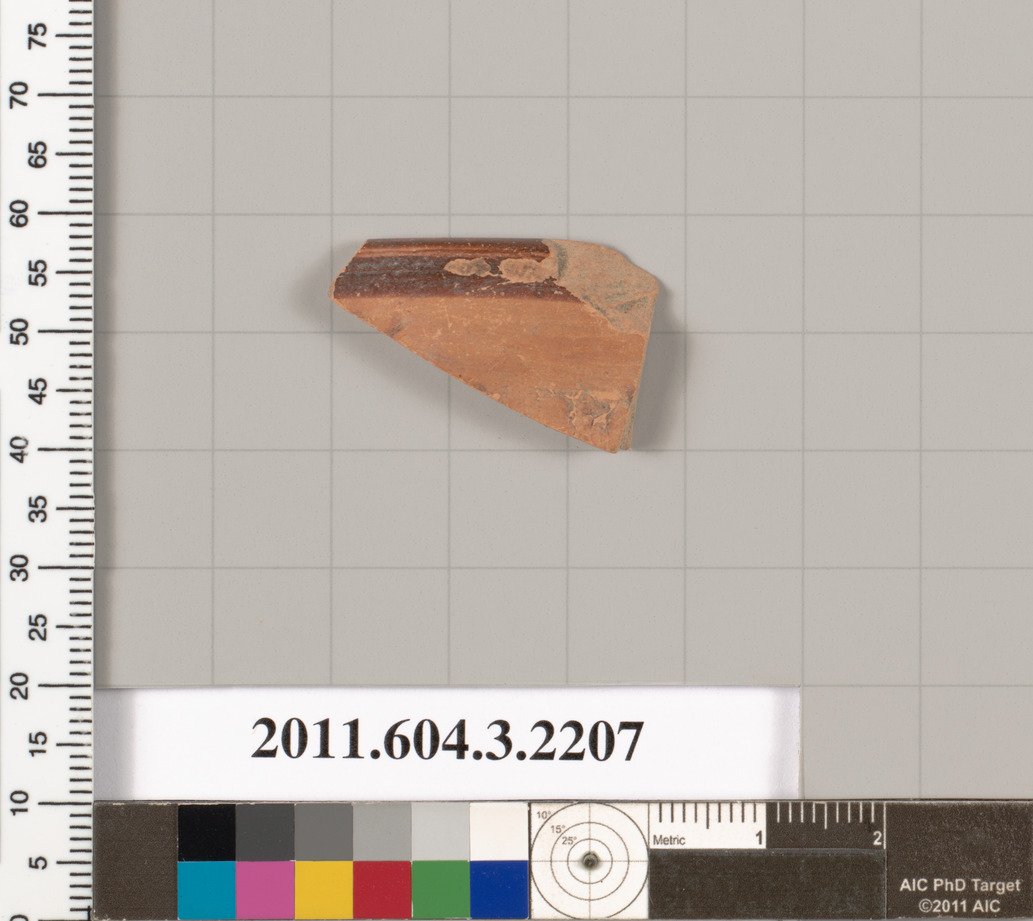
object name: kylix fragment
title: Terracotta fragment of a kylix (drinking cup)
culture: greek, attic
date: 600-401 BCE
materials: terracotta